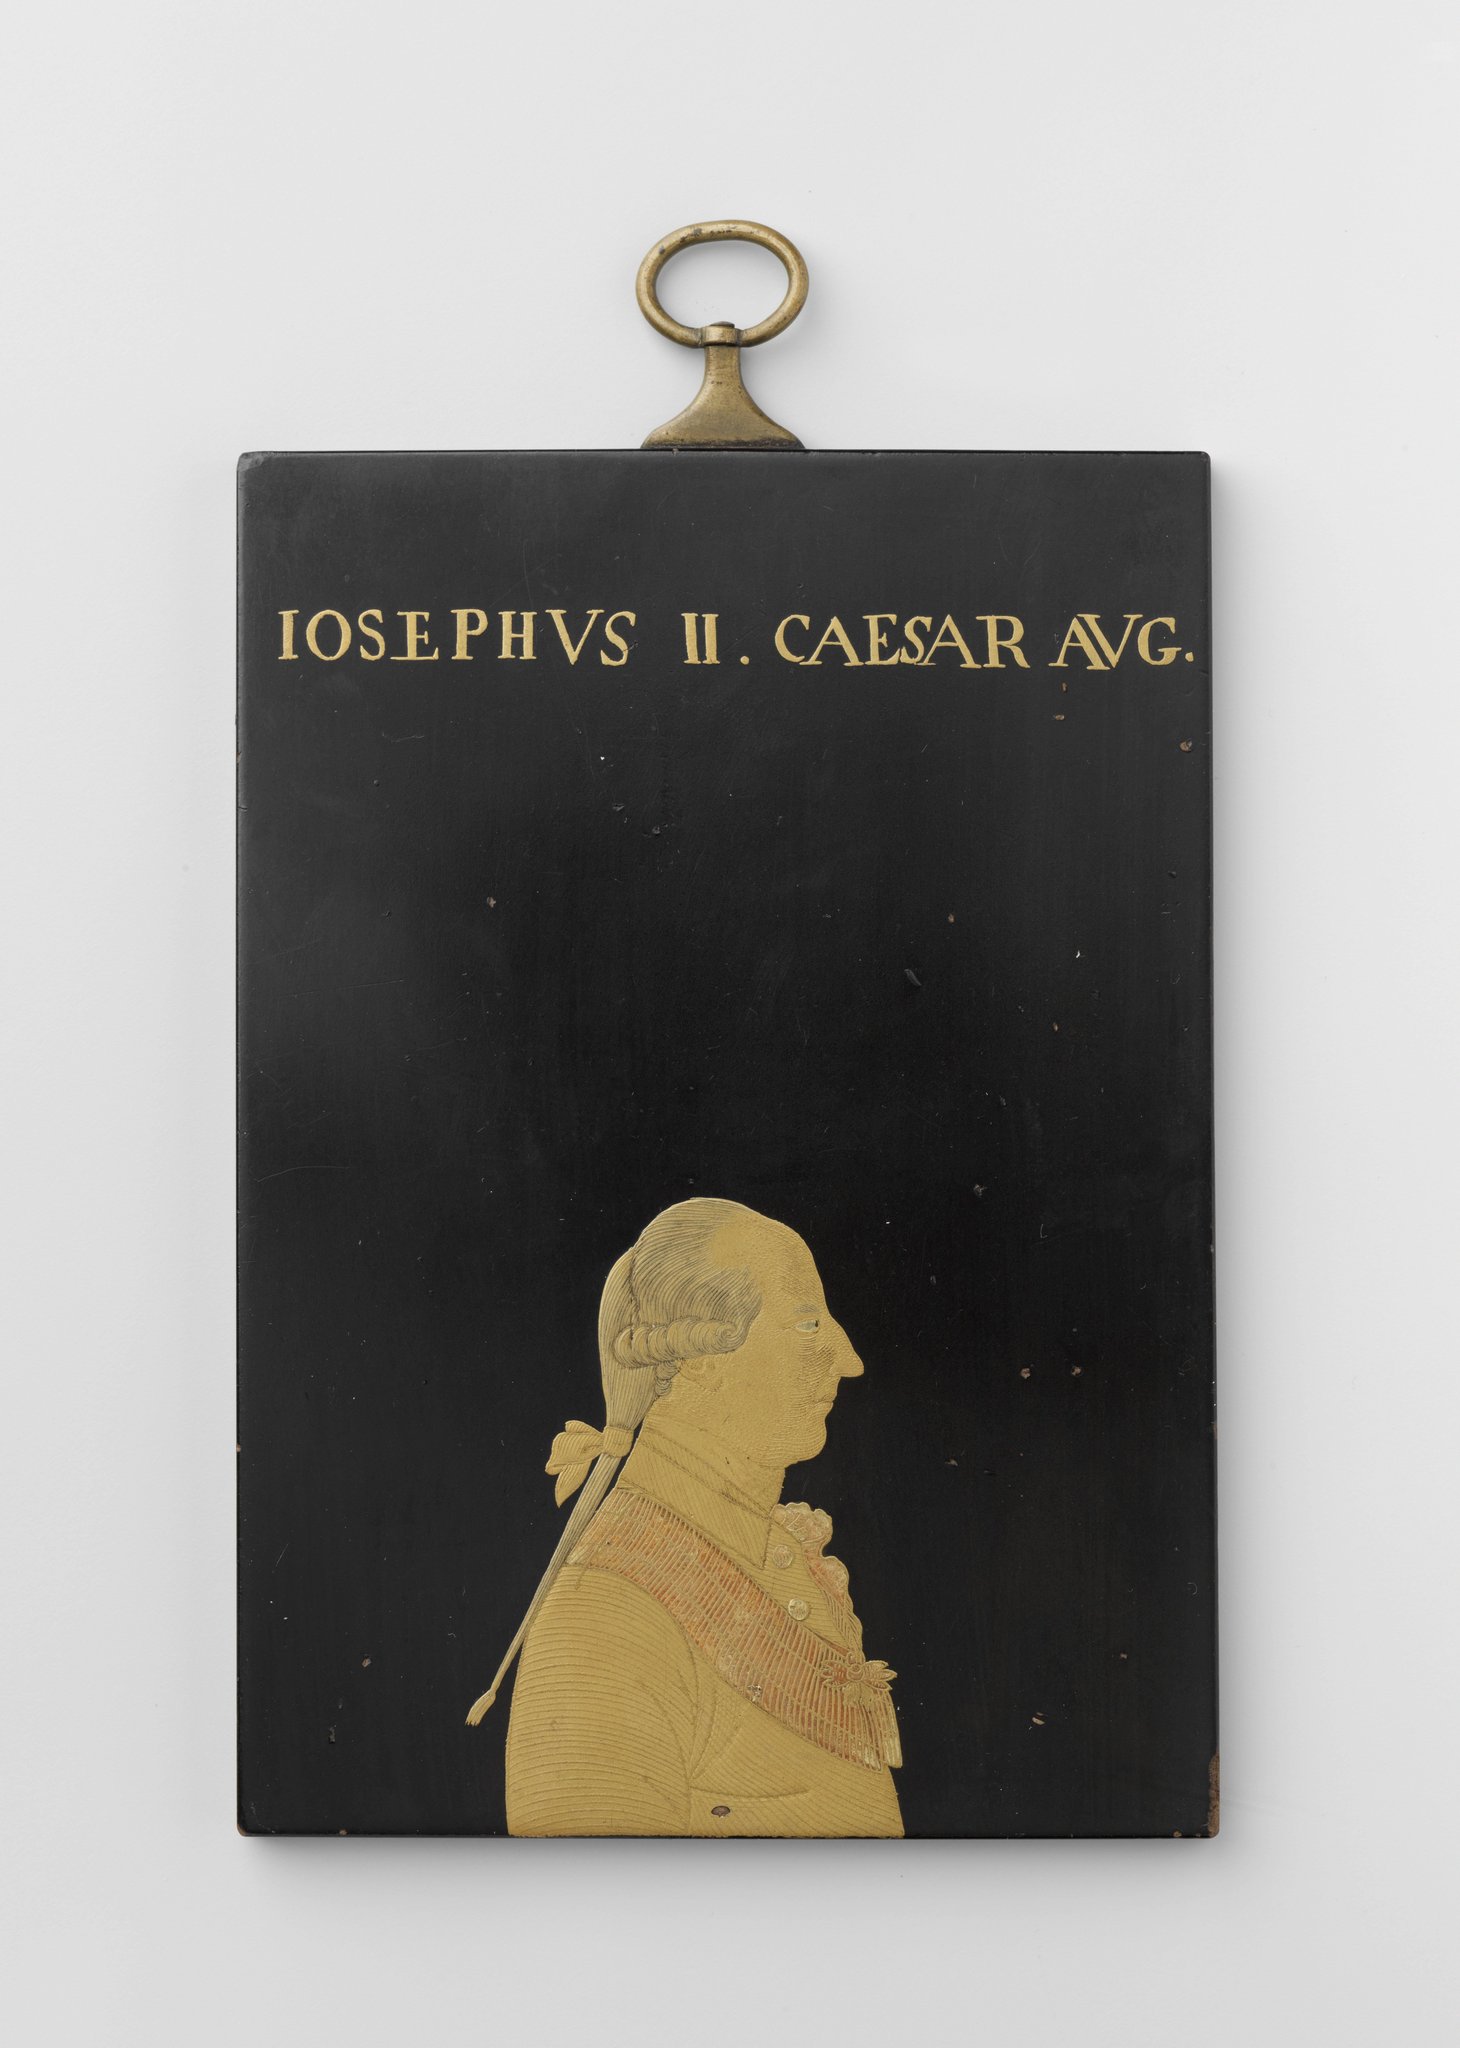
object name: plaque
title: Jozef II van Oosterijk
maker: Anonymous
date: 1775-1800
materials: copper, lacquer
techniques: lacquer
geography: japan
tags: jozef ii (duits keizer)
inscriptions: inscription: ‘Rvdolphos. Carolos. Fernandos. Max...ilioanos / Cernis. In. Hoo. Vno. Terra. Beata. Viro’, inscription: ‘IOSEPHUS II. CAESAR AVG.’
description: Portraits of European monarchs and scholars. Japan, last quarter 18th century. The VOC exported lacquer products commissioned specifically for the European market. Working from European prints, Japanese craftsmen made series of portraits for the VOC.